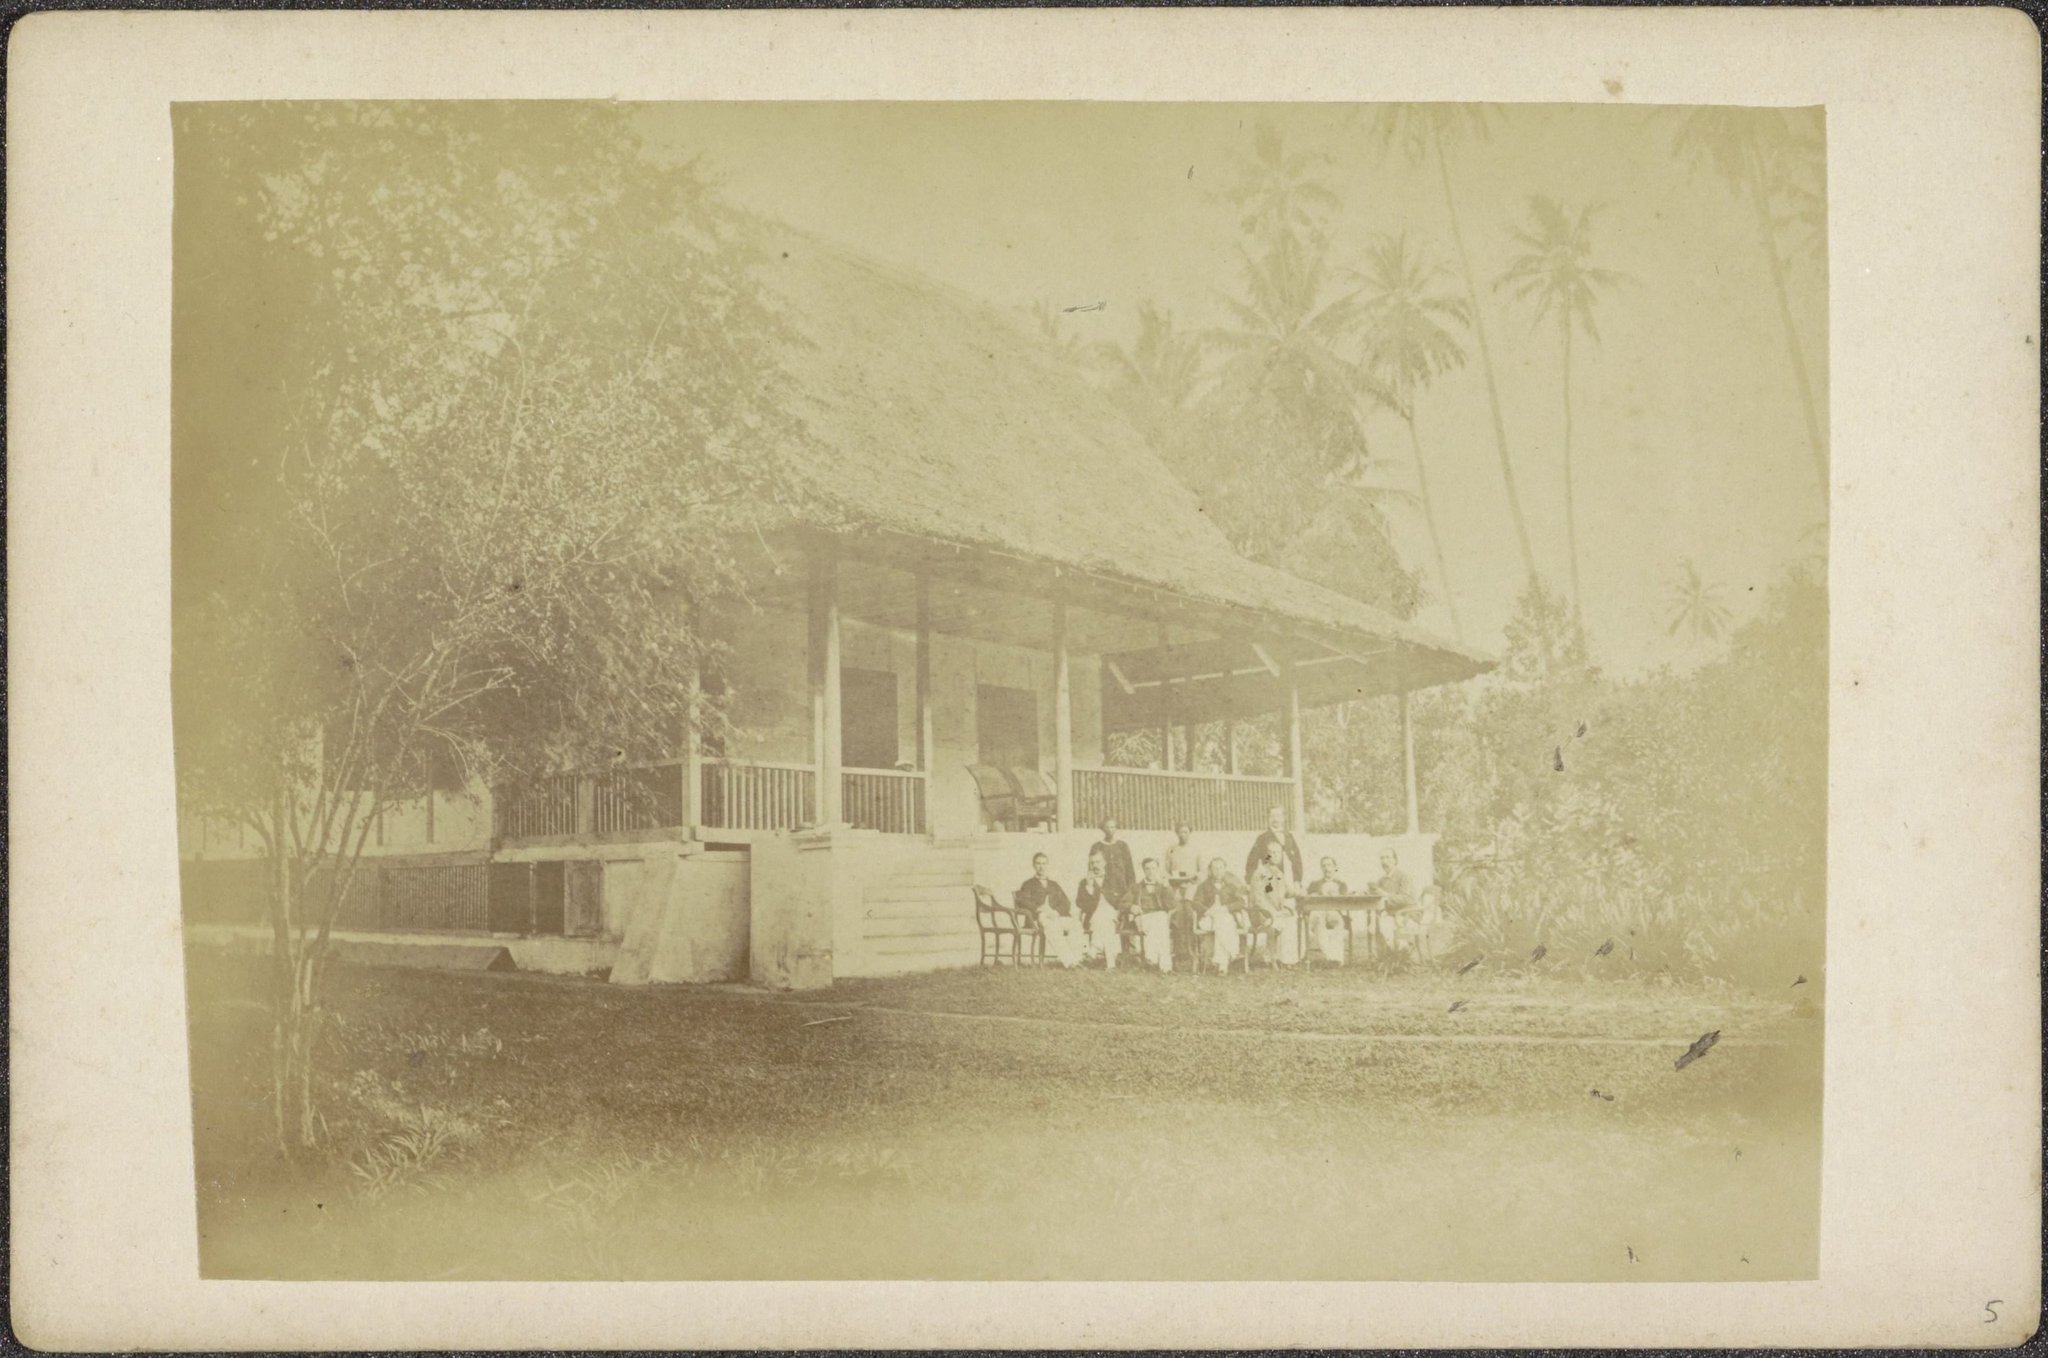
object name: photograph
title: Gezelschap poserend voor de woning van de heer Renesse van Duivenbode op Halmahera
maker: Anonymous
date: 1860-1900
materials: cardboard, paper, photographic support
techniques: albumen print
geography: halmahera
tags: rural housing, e.g. country-house, villa, cottage, dutch east indies, the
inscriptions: inscription: ‘Molukken. Een woning op Halmaheira van den Heer Renesse van Duivenbode’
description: Onderdeel van Album met foto's van de Molukken.